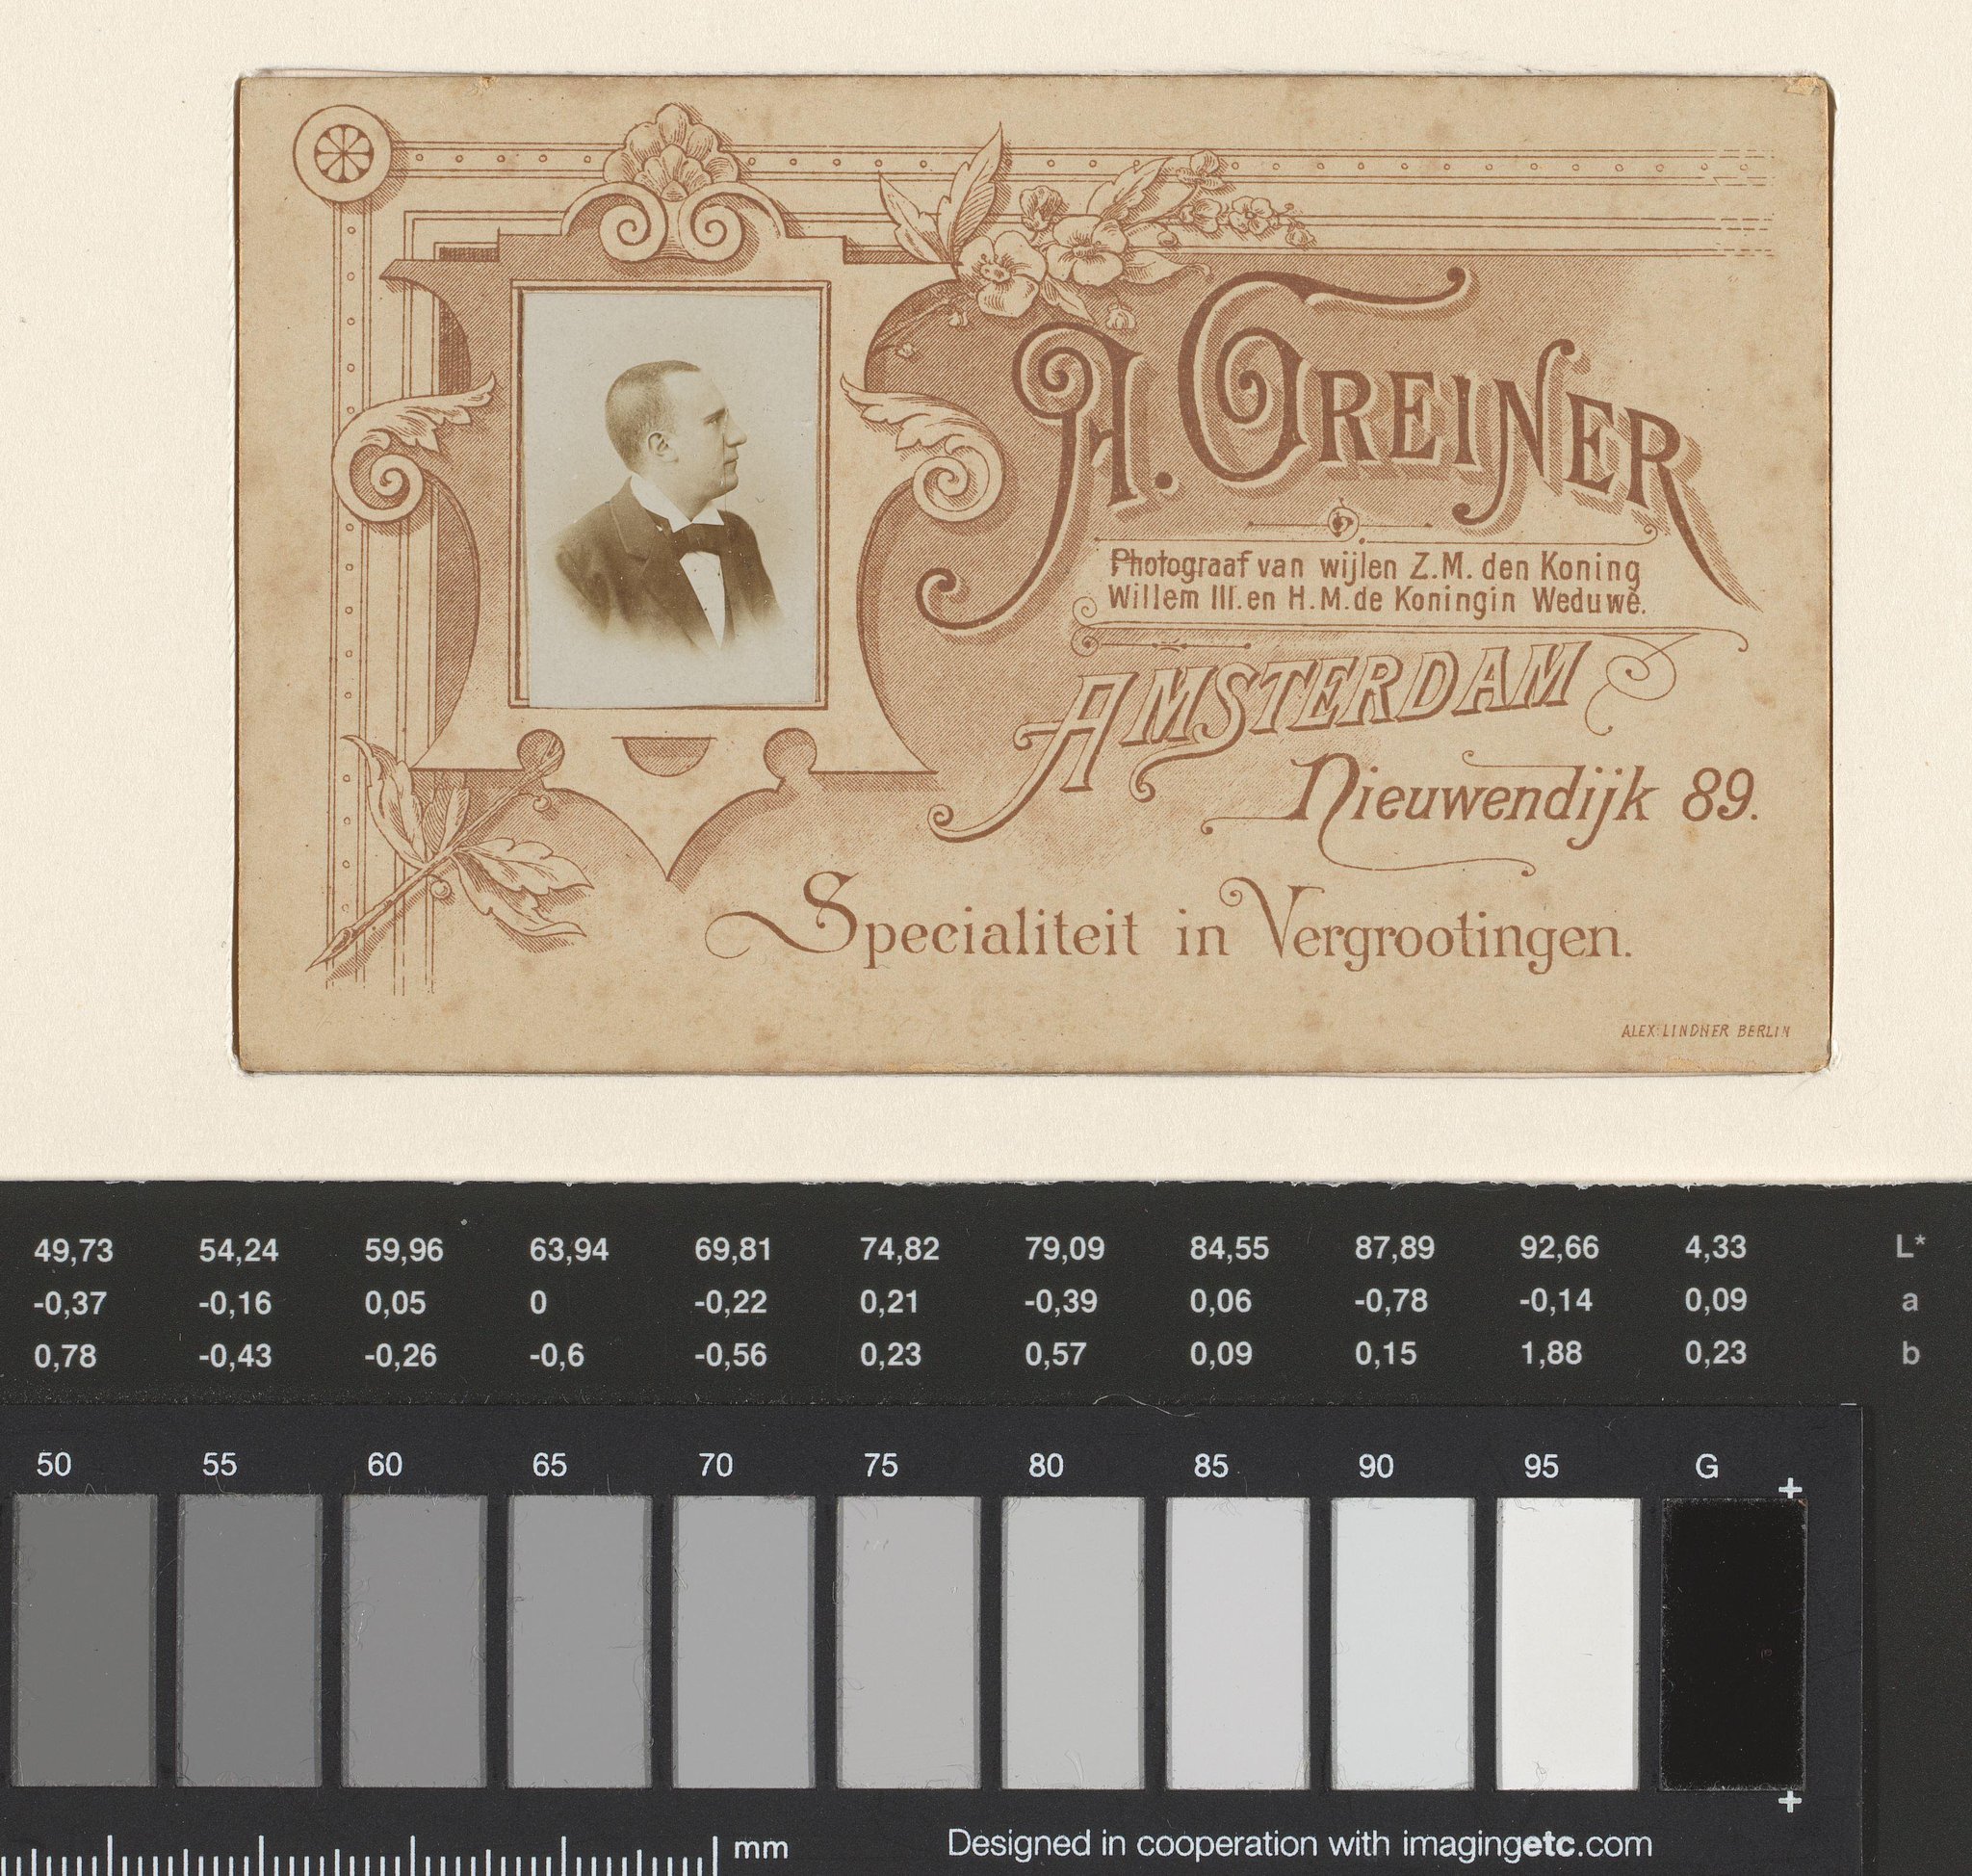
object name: photograph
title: Visitekaartje van fotograaf A. Greiner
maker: albert greiner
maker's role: fotograaf, fotostudio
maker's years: 1833-1890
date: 1879-1900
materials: cardboard, paper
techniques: collodion silver print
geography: amsterdam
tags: visiting-card, calling-card, netherlands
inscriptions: annotation: ‘Prijs Courant... (’, name: ‘A. Greiner. Photograaf van wijlen Z.M. den Koning Willem III en H.M. de Koningin Weduwe. Amsterdam Nieuwendijk 89. Specialiteit in vergrootingen’